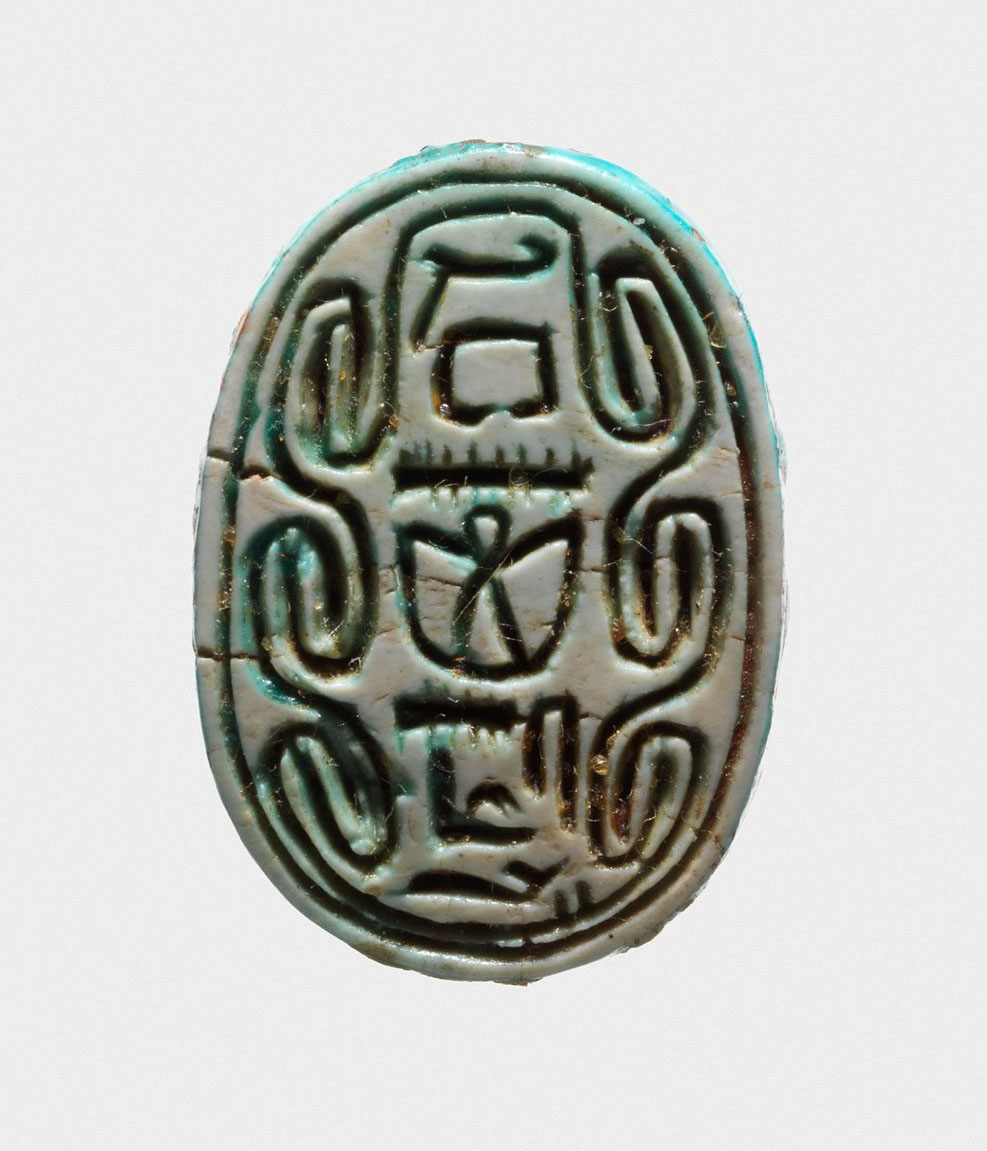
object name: scarab, steward senebtifi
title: Scarab of the Steward of Cusae, Senebtifi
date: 1981-1802 BCE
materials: stone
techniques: glazing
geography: egypt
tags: hieroglyphs,scarabs